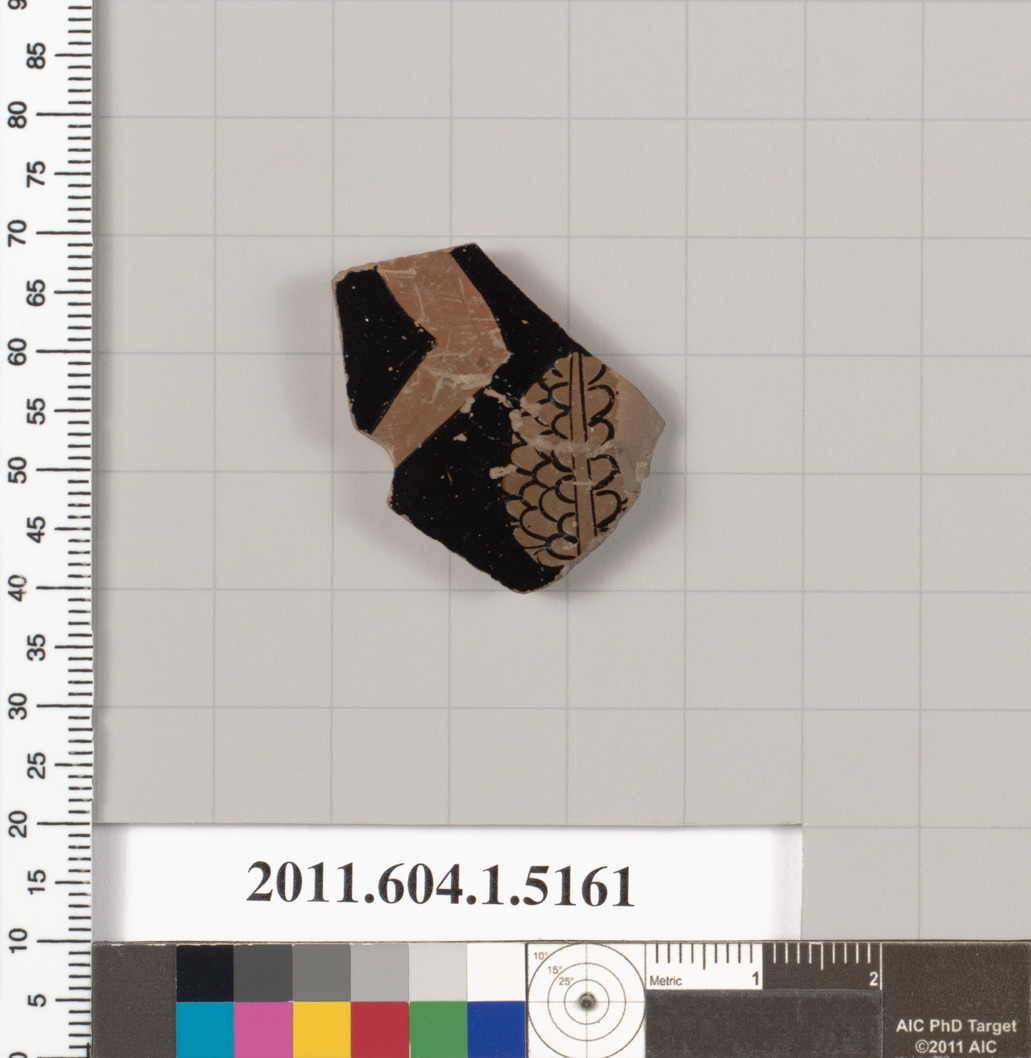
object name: kylix fragment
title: Terracotta fragment of a kylix (drinking cup)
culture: greek, attic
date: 500-480 BCE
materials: terracotta